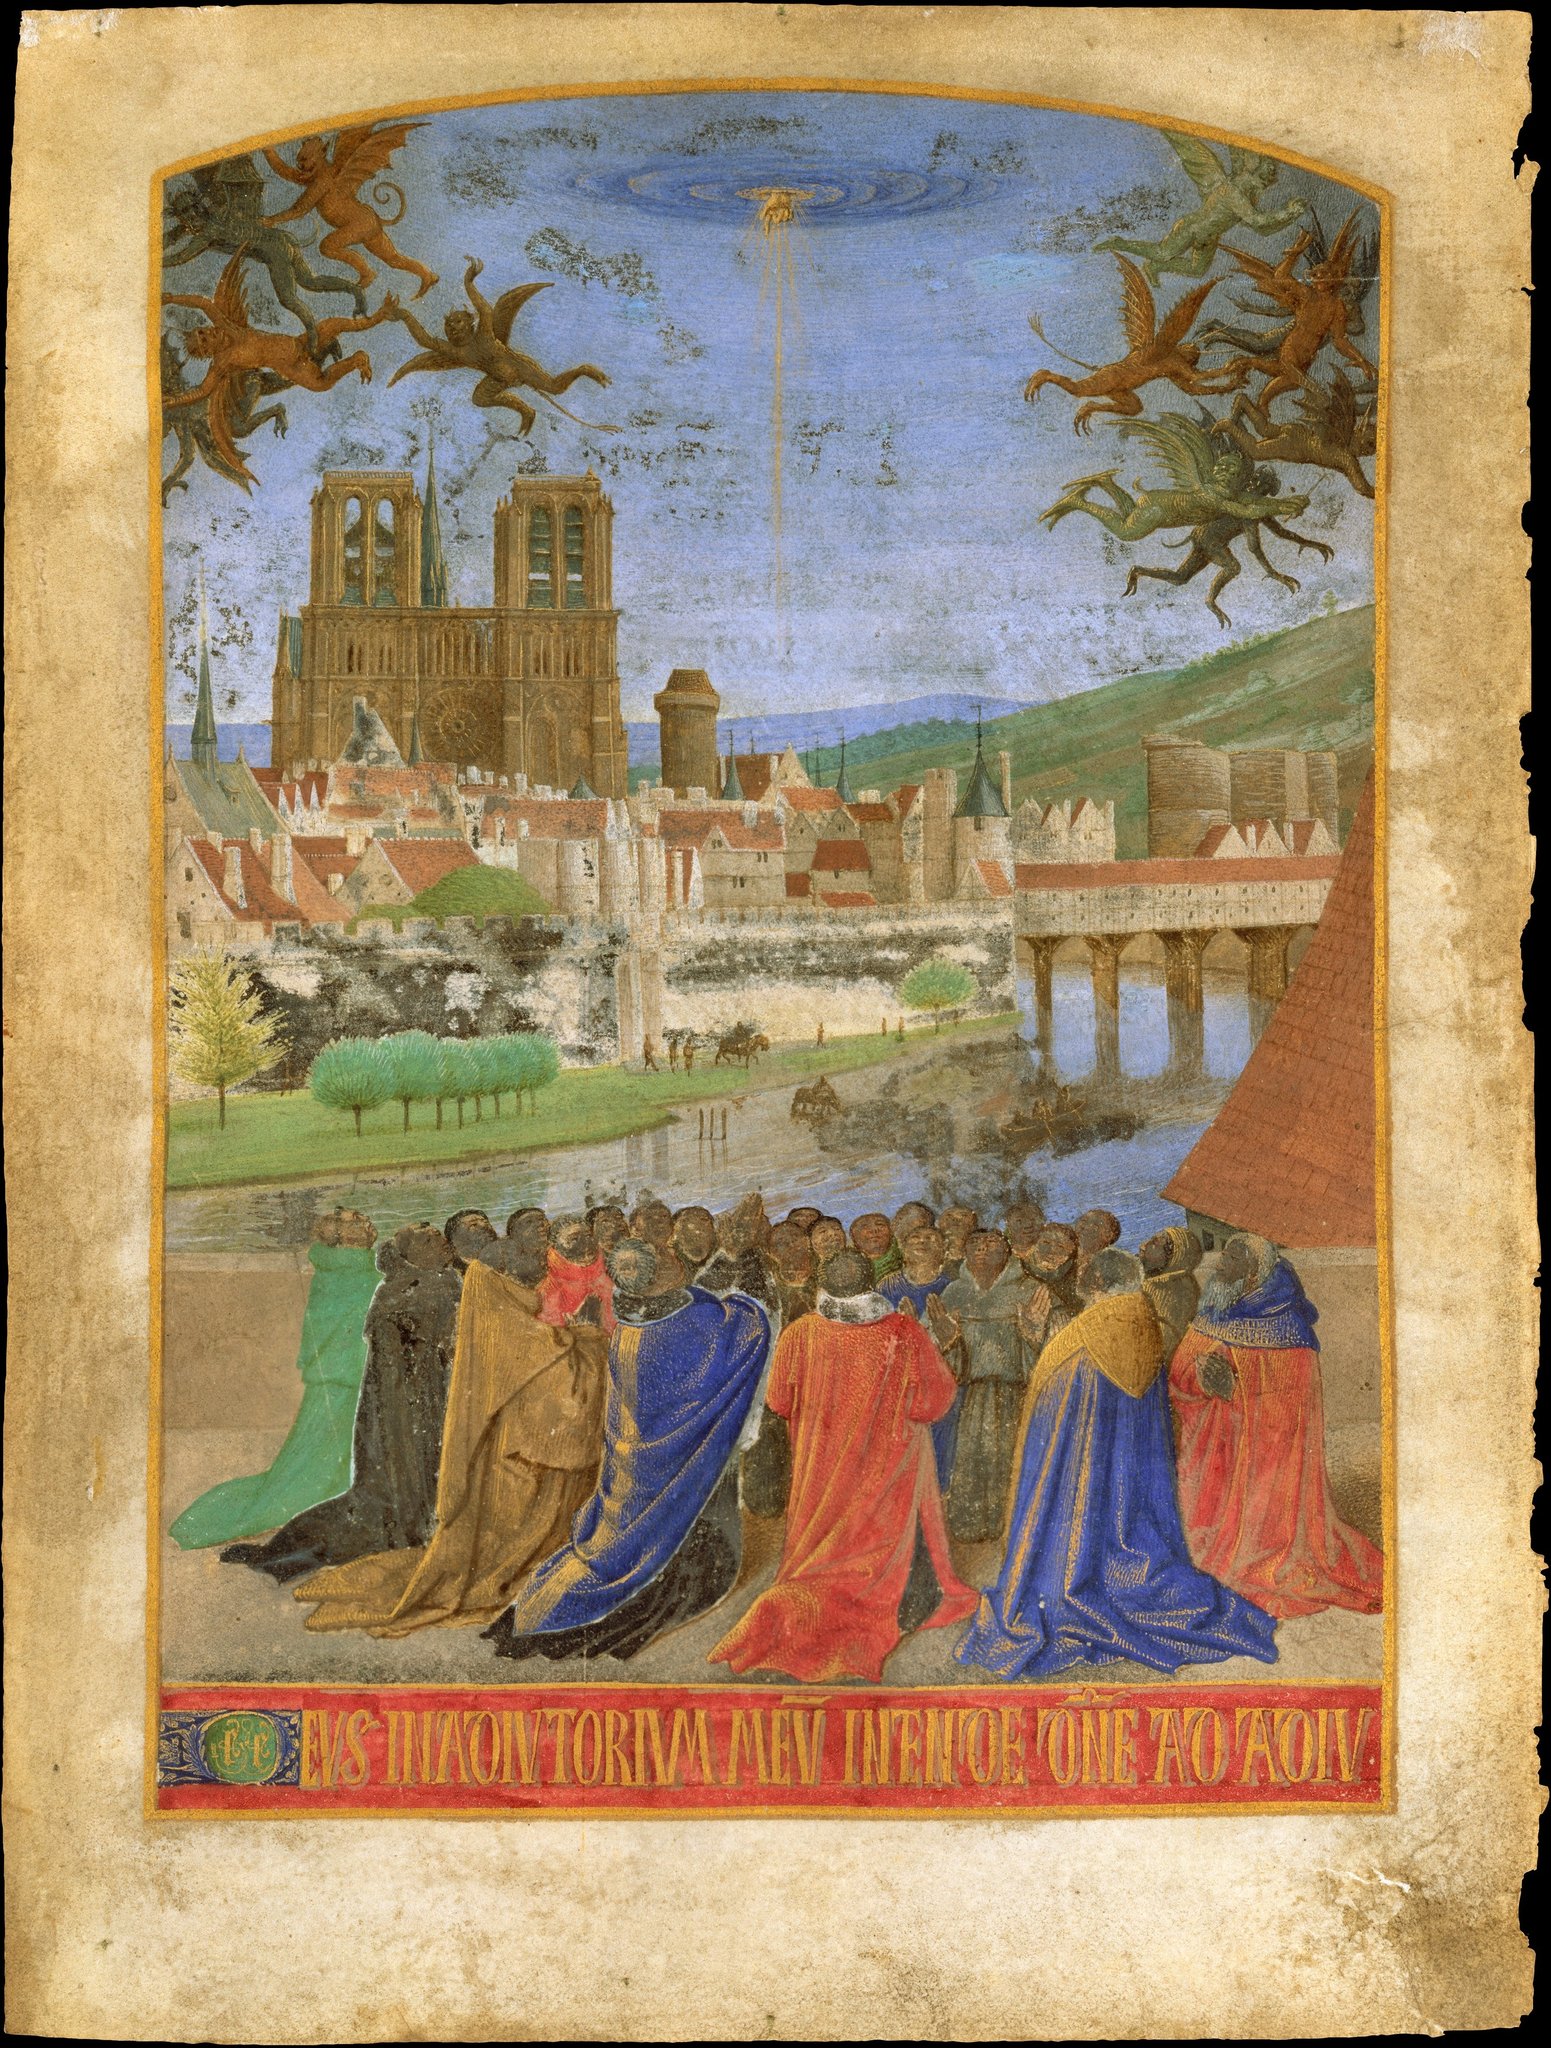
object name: leaf from manuscript, illumination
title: The Right Hand of God Protecting the Faithful against the Demons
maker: jean fouquet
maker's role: artist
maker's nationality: french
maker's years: 1425-1478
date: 1452-1460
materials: gold leaf, parchment, paint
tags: cities,men,demons